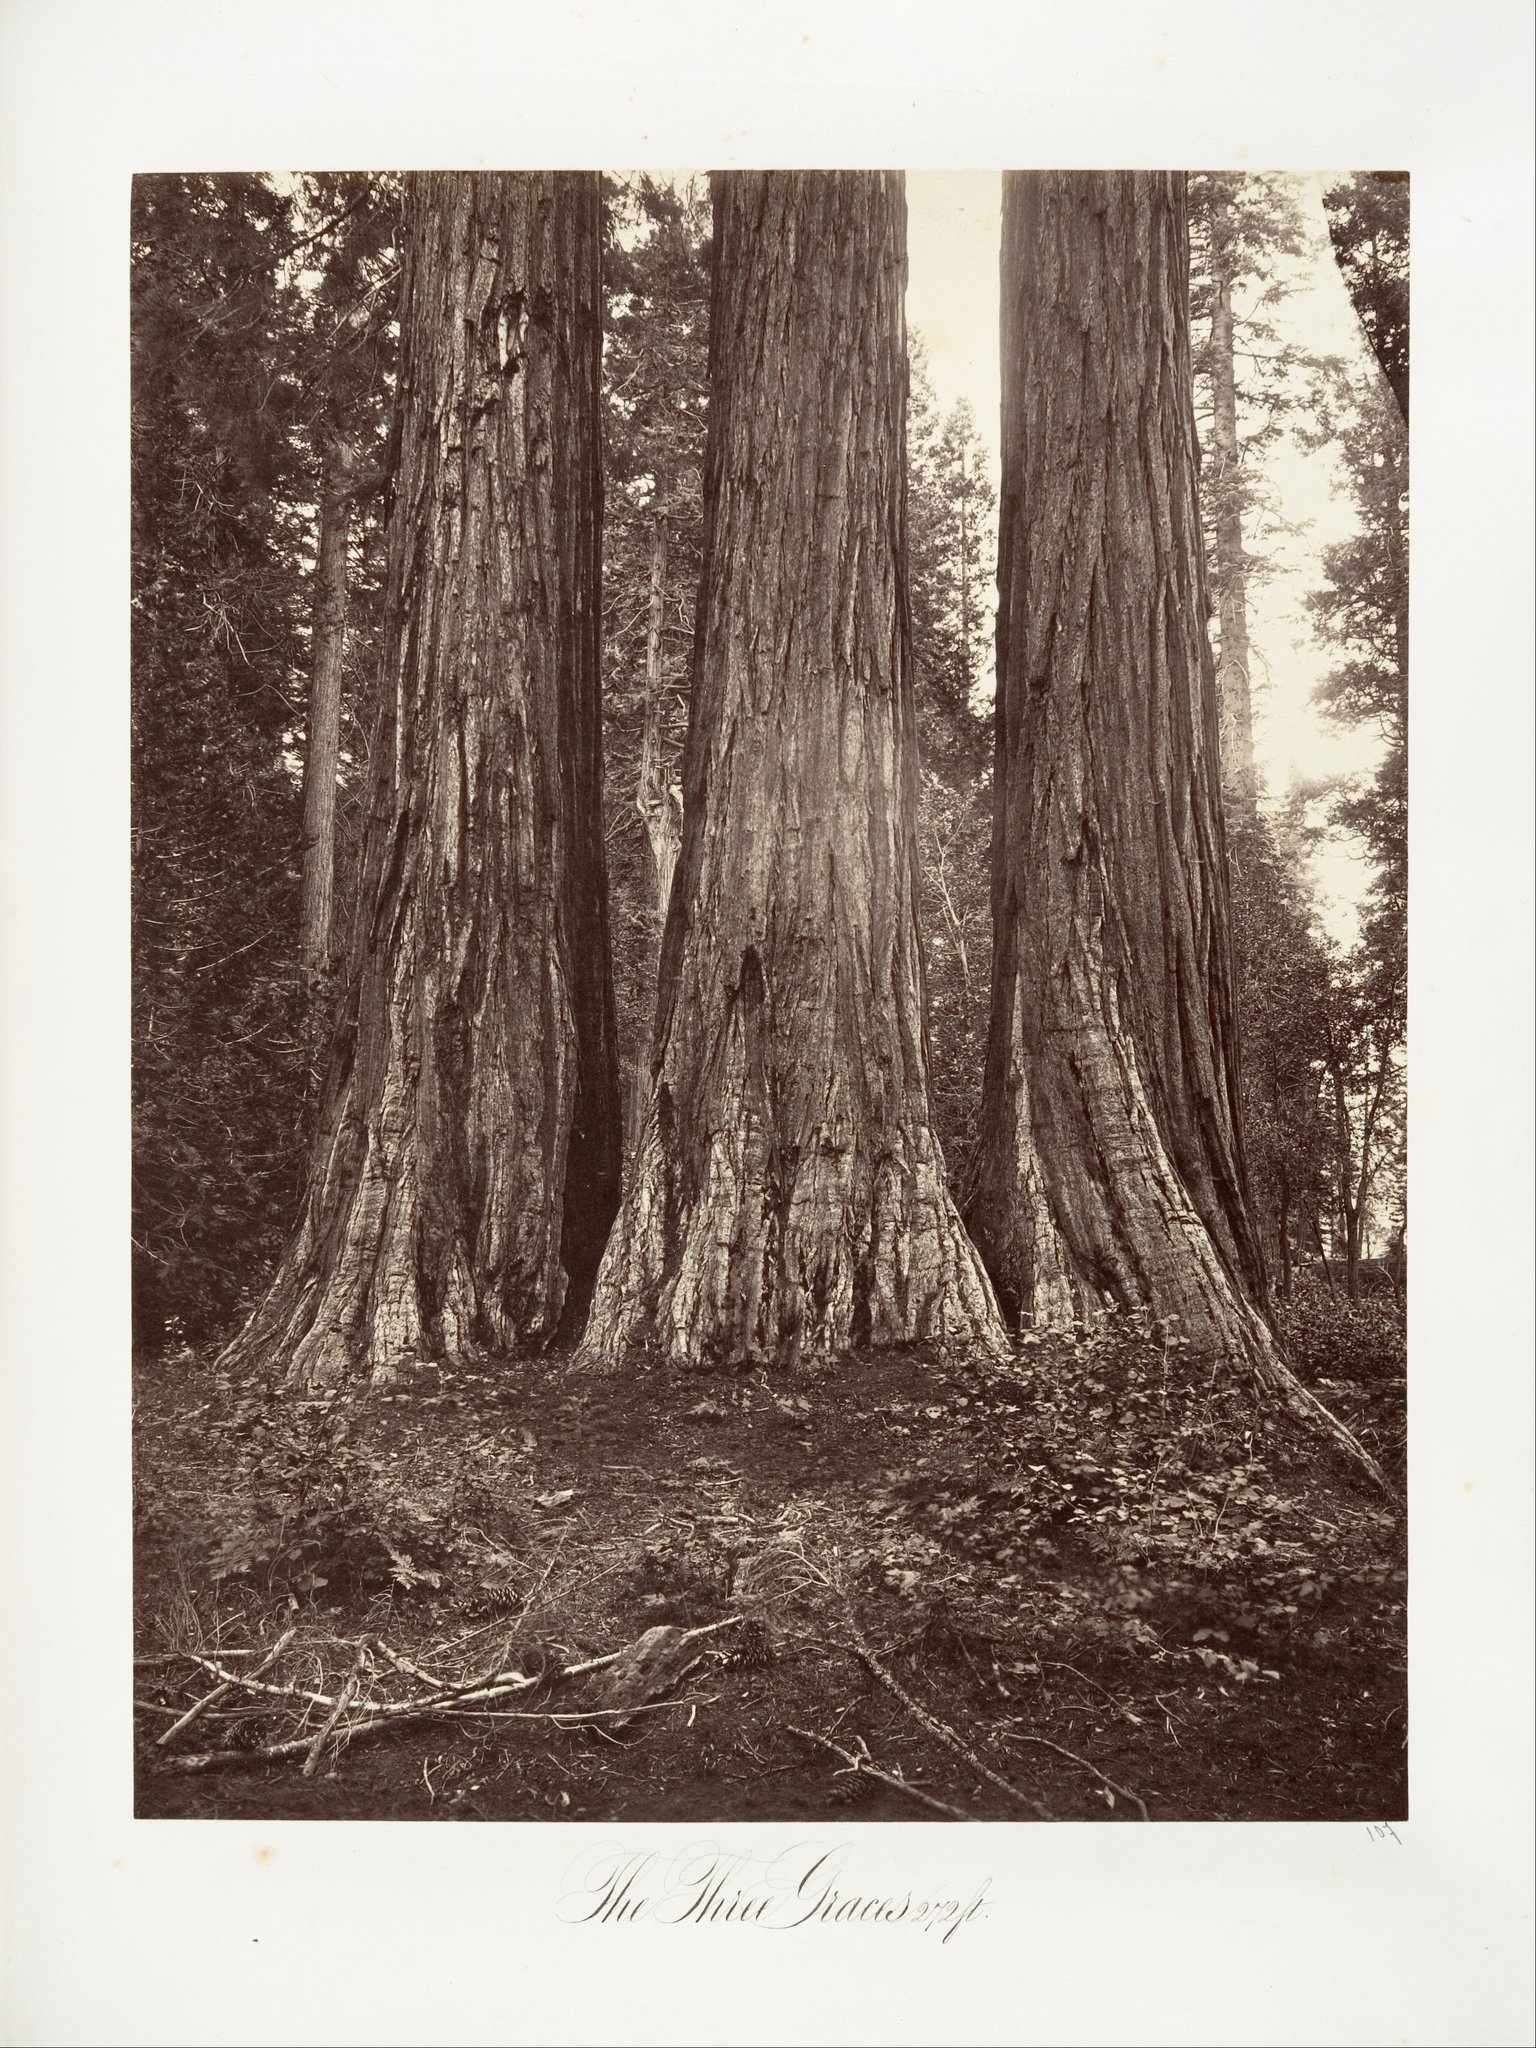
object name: photograph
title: The Three Graces, 272 feet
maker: carleton e. watkins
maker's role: artist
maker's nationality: american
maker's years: 1829-1916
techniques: albumen silver print, glass negative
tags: forests,trees